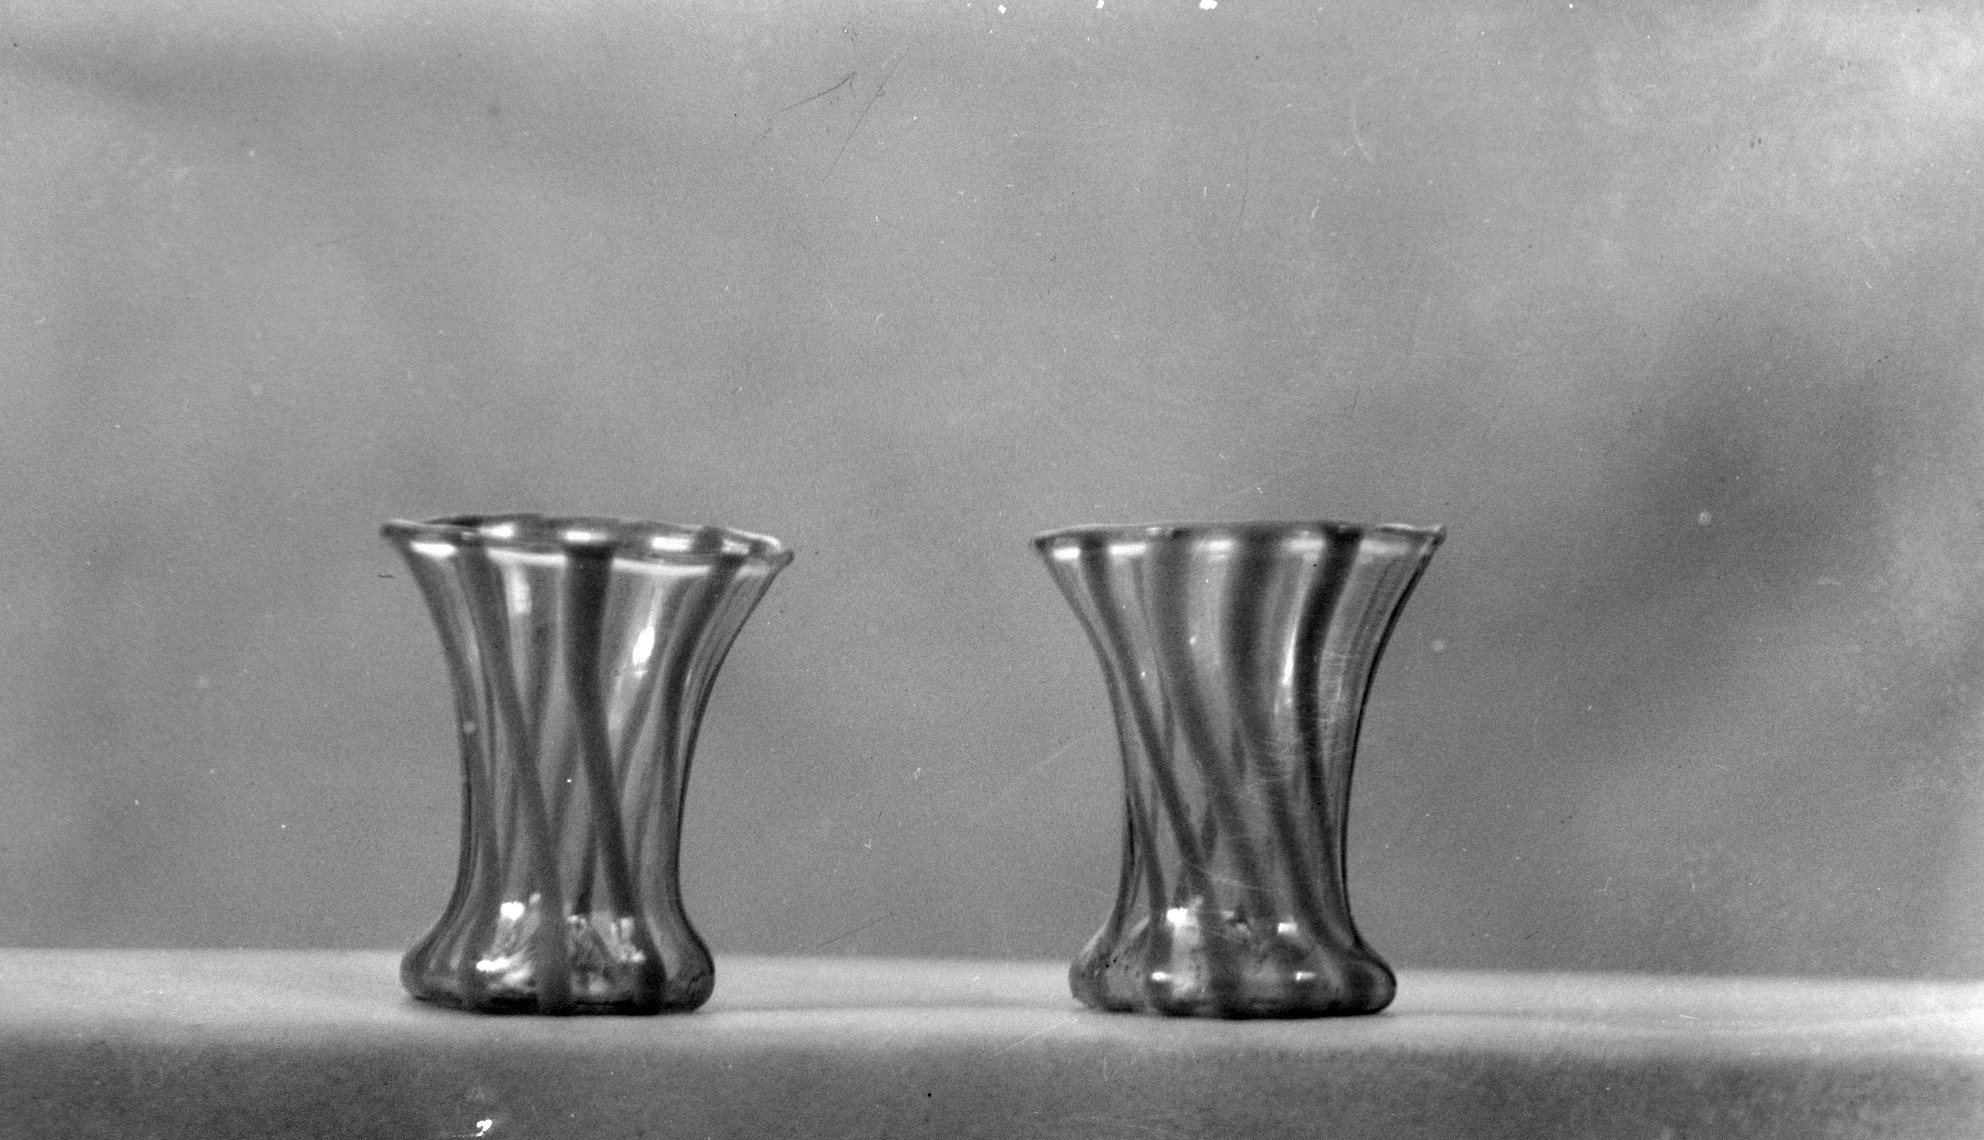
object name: beaker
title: Miniature beaker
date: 1801-1833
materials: glass